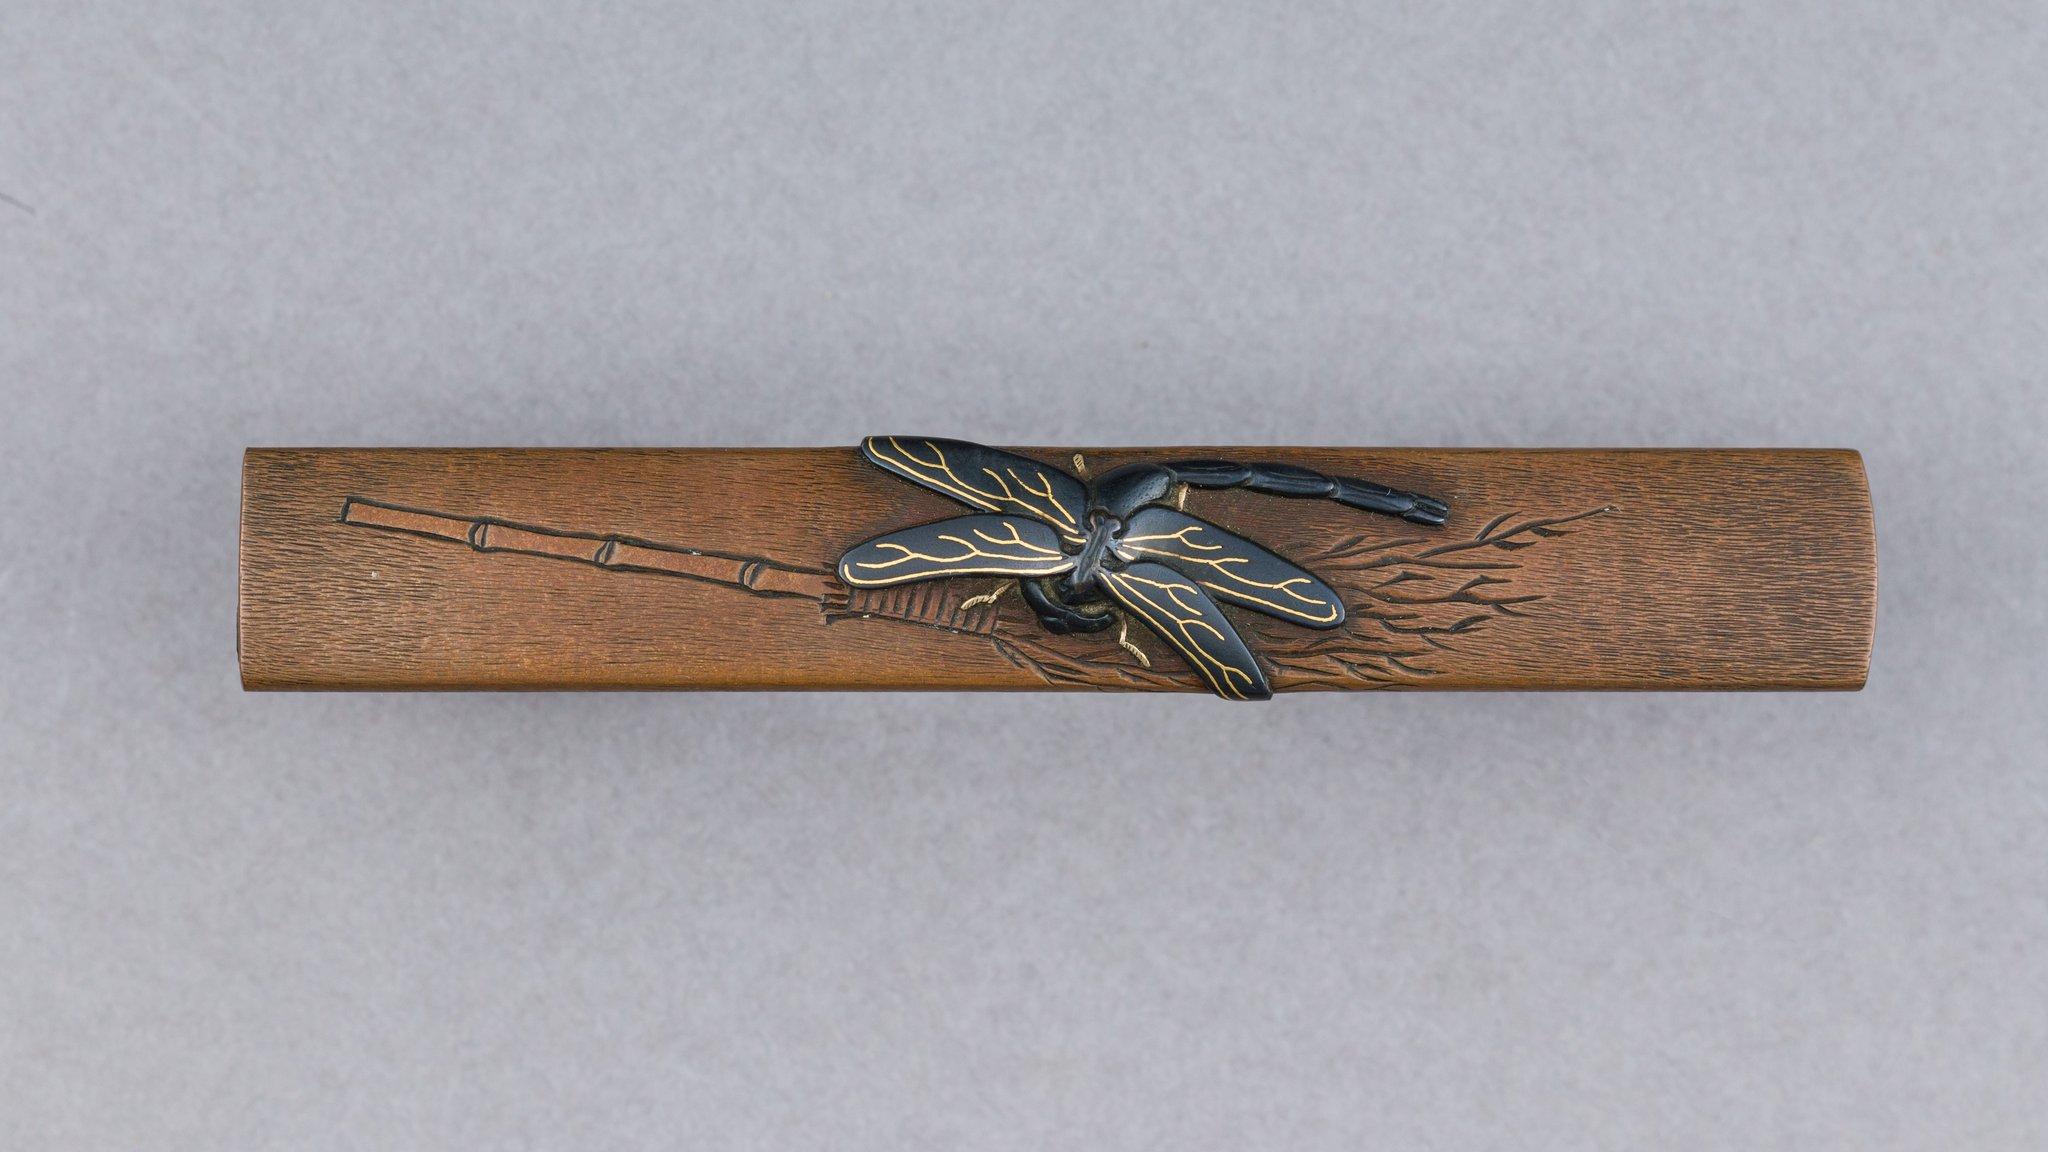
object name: knife handle kozuka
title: Knife Handle (Kozuka)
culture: japanese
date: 1701-1800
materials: copper, gold alloy, gold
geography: japan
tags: dragonflies